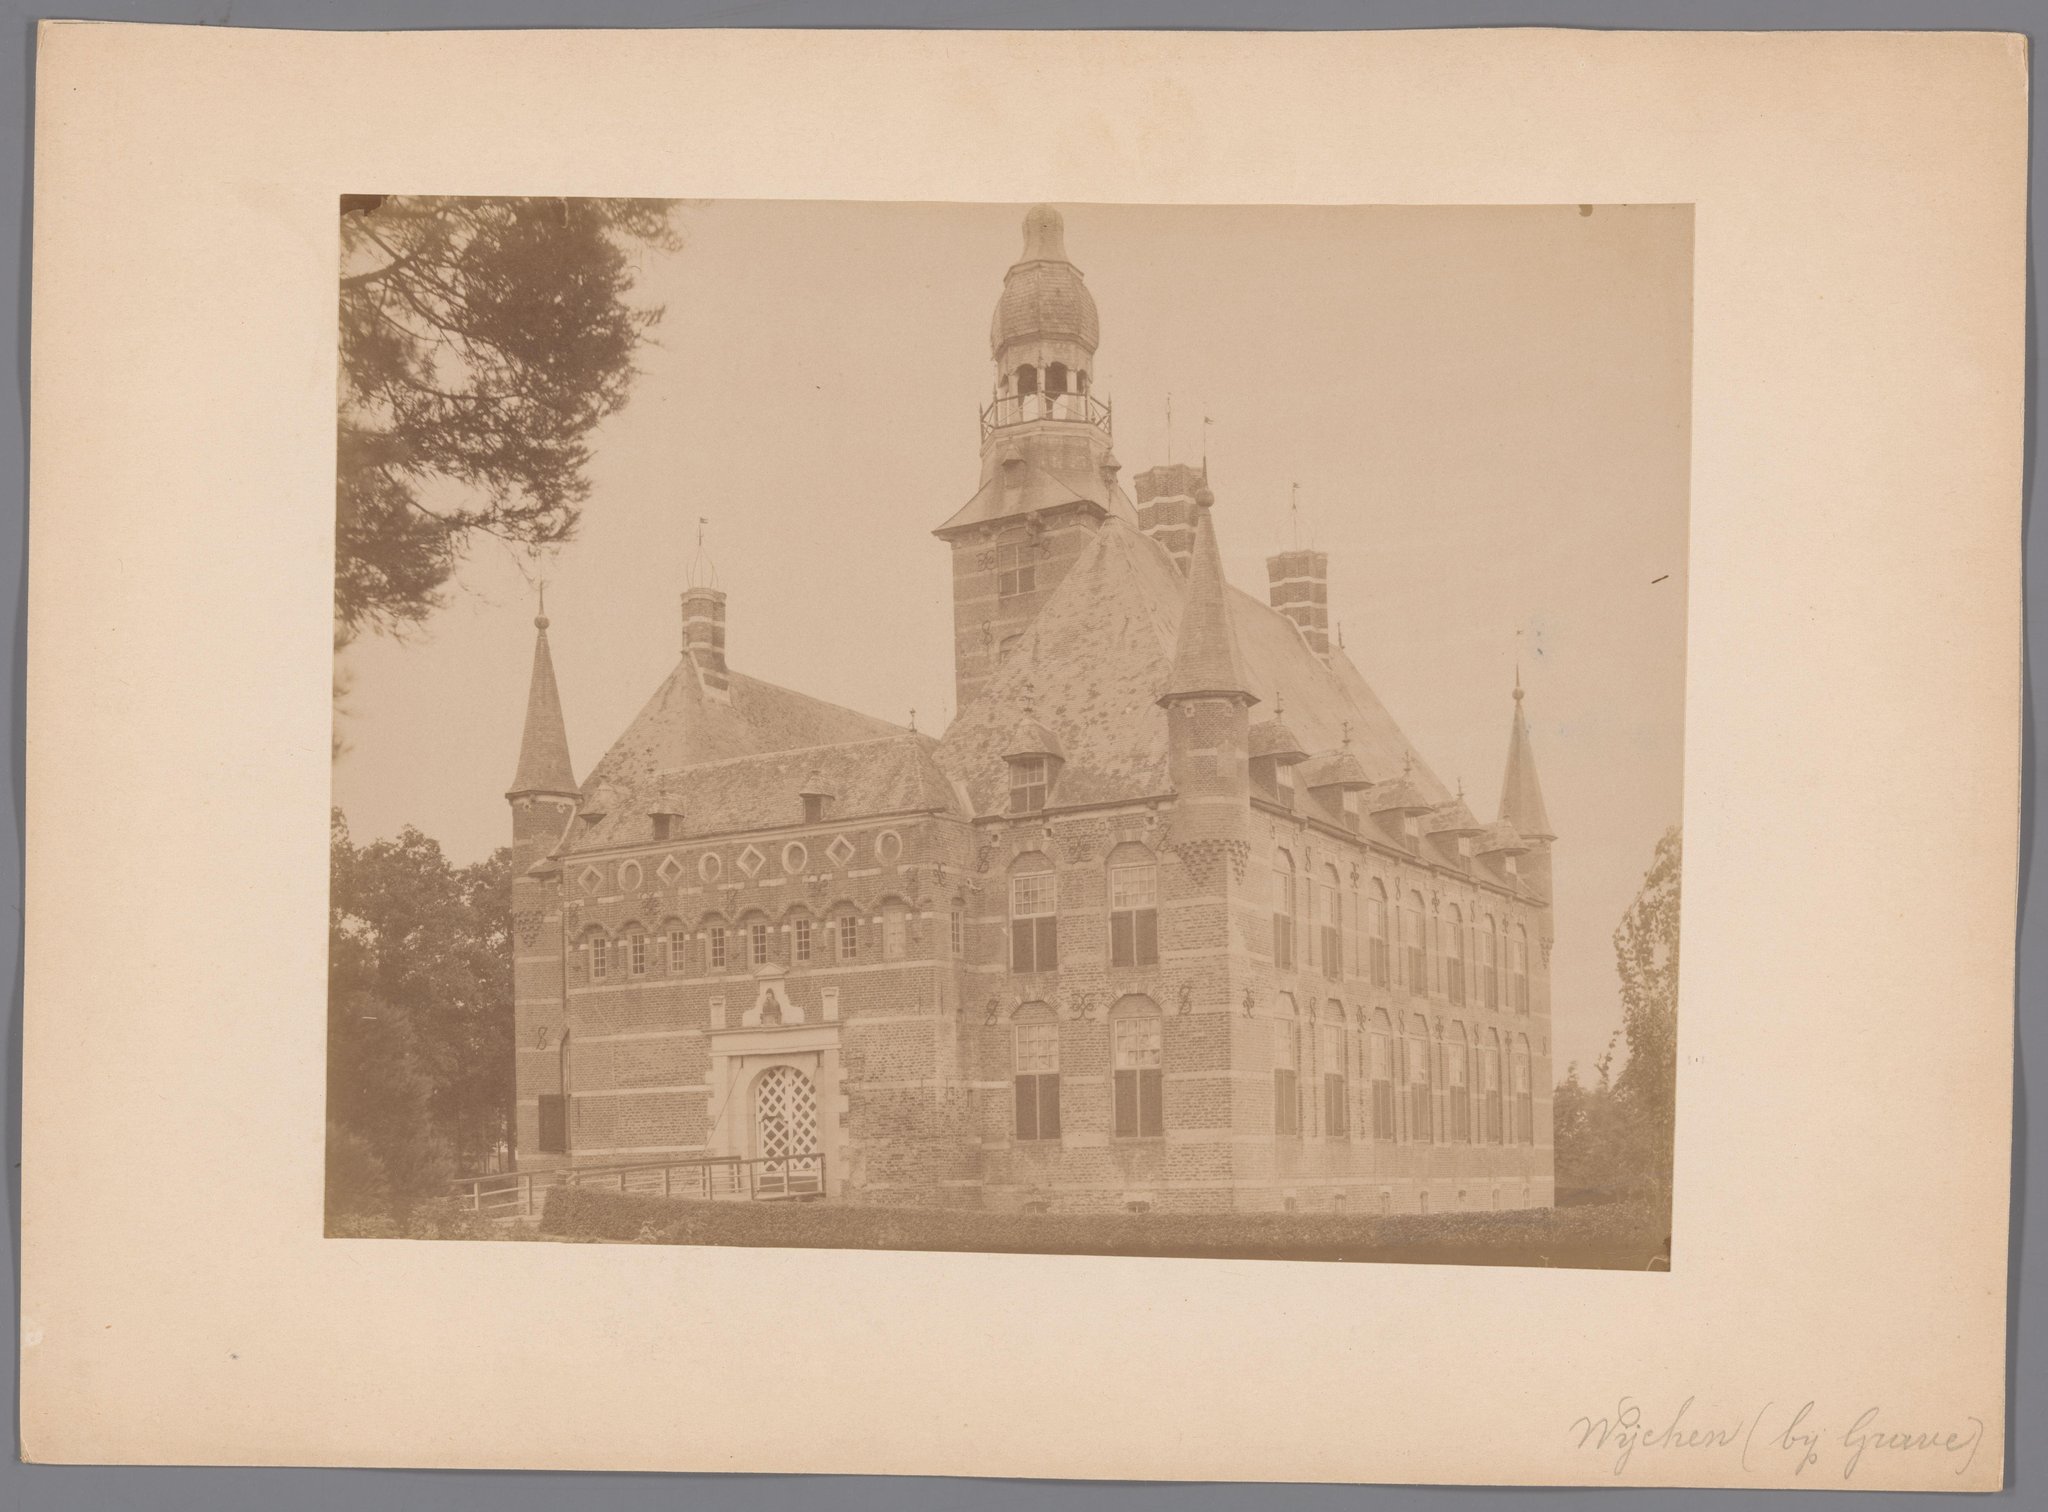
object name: photograph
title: Kasteel van Wijchen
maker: anoniem (monumentenzorg)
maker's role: fotograaf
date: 1890-1906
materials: cardboard, photographic support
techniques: albumen print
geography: wijchen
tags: castle, landscape with tower or castle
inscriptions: annotation: ‘Kasteel Wijchen/ bij Grave’, annotation: ‘Wijchen (bij Grave)’